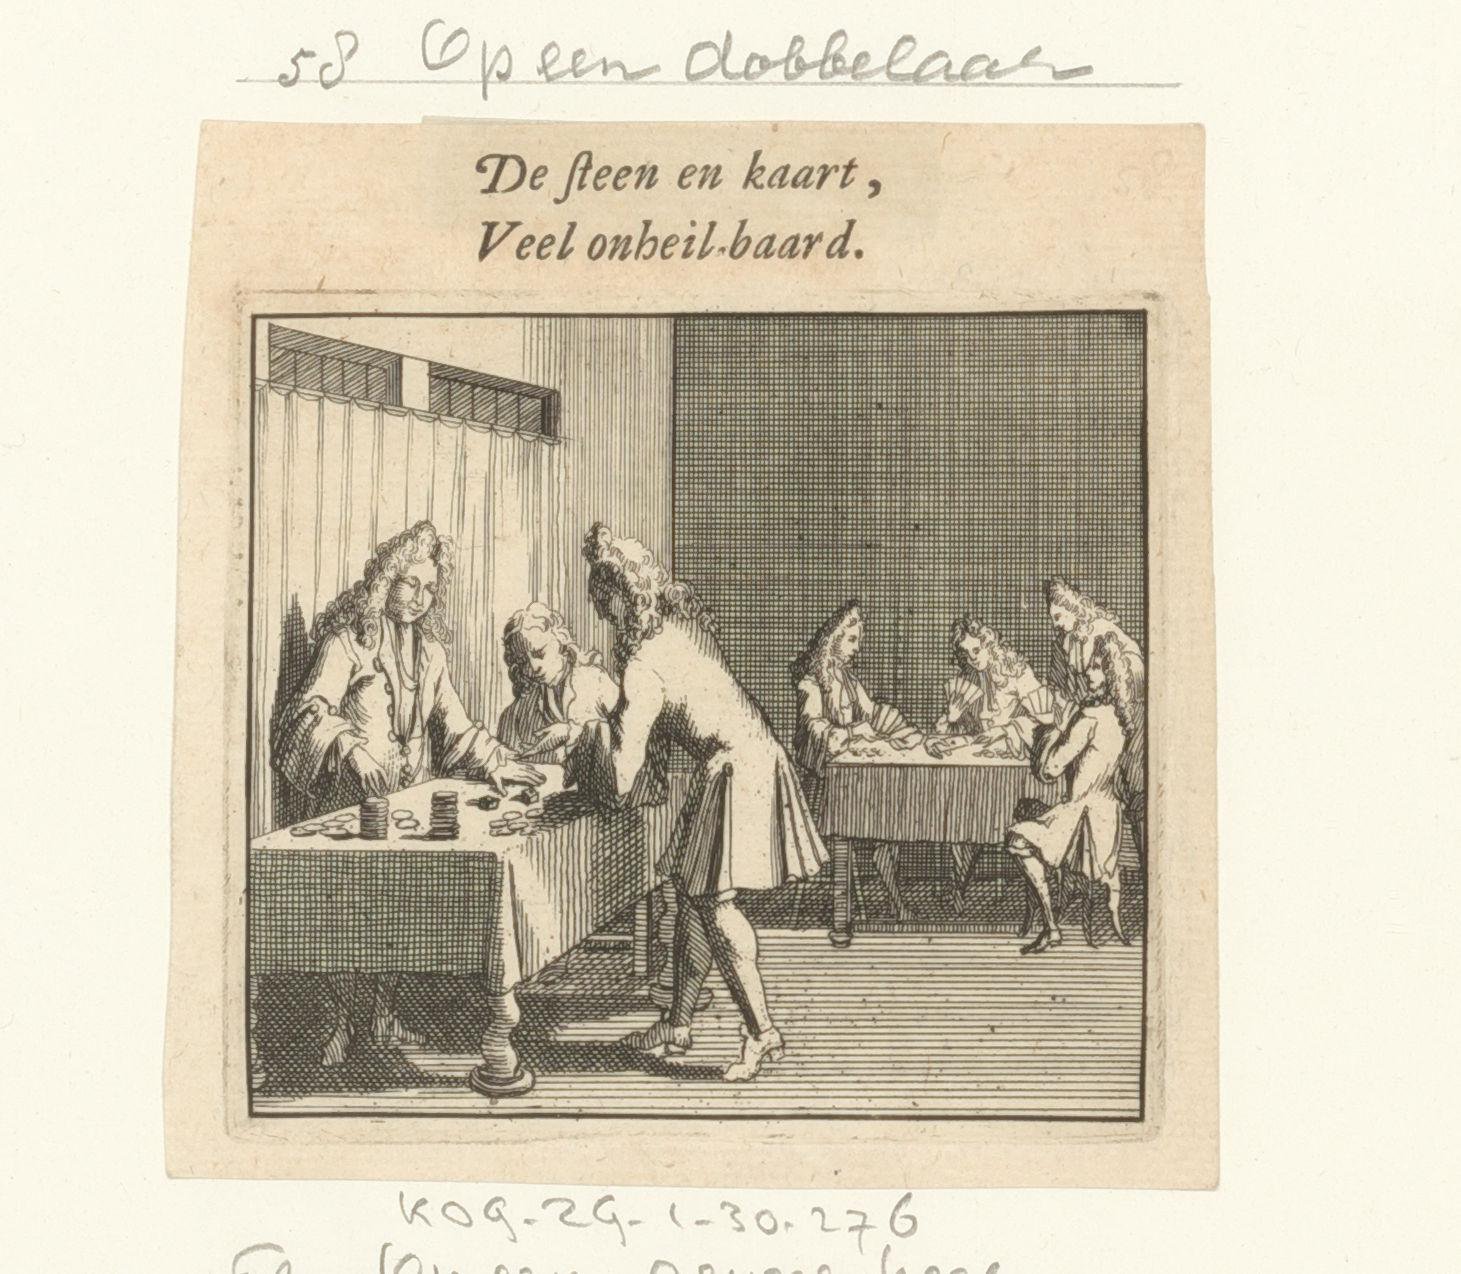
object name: print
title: De steen en kaart, Veel onheil-baard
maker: cornelis huyberts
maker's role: print maker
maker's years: 1669-1709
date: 1725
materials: paper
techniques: etching, letterpress printing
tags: card games, dice-games, playing-cards, gaming den, gambling den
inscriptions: collector's mark: Lugt 1641, stamp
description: Prent uit: Graauwhart, Hendrik. Voorbeeldelyke zeede-lessen, genoomen uyt den eersten toestand des werelds (...). Amsterdam: Johannes Ratelband, 1725. Prent ook gebruikt voor eerdere en (1709) latere uitgave (1756, 1761 en 1764).